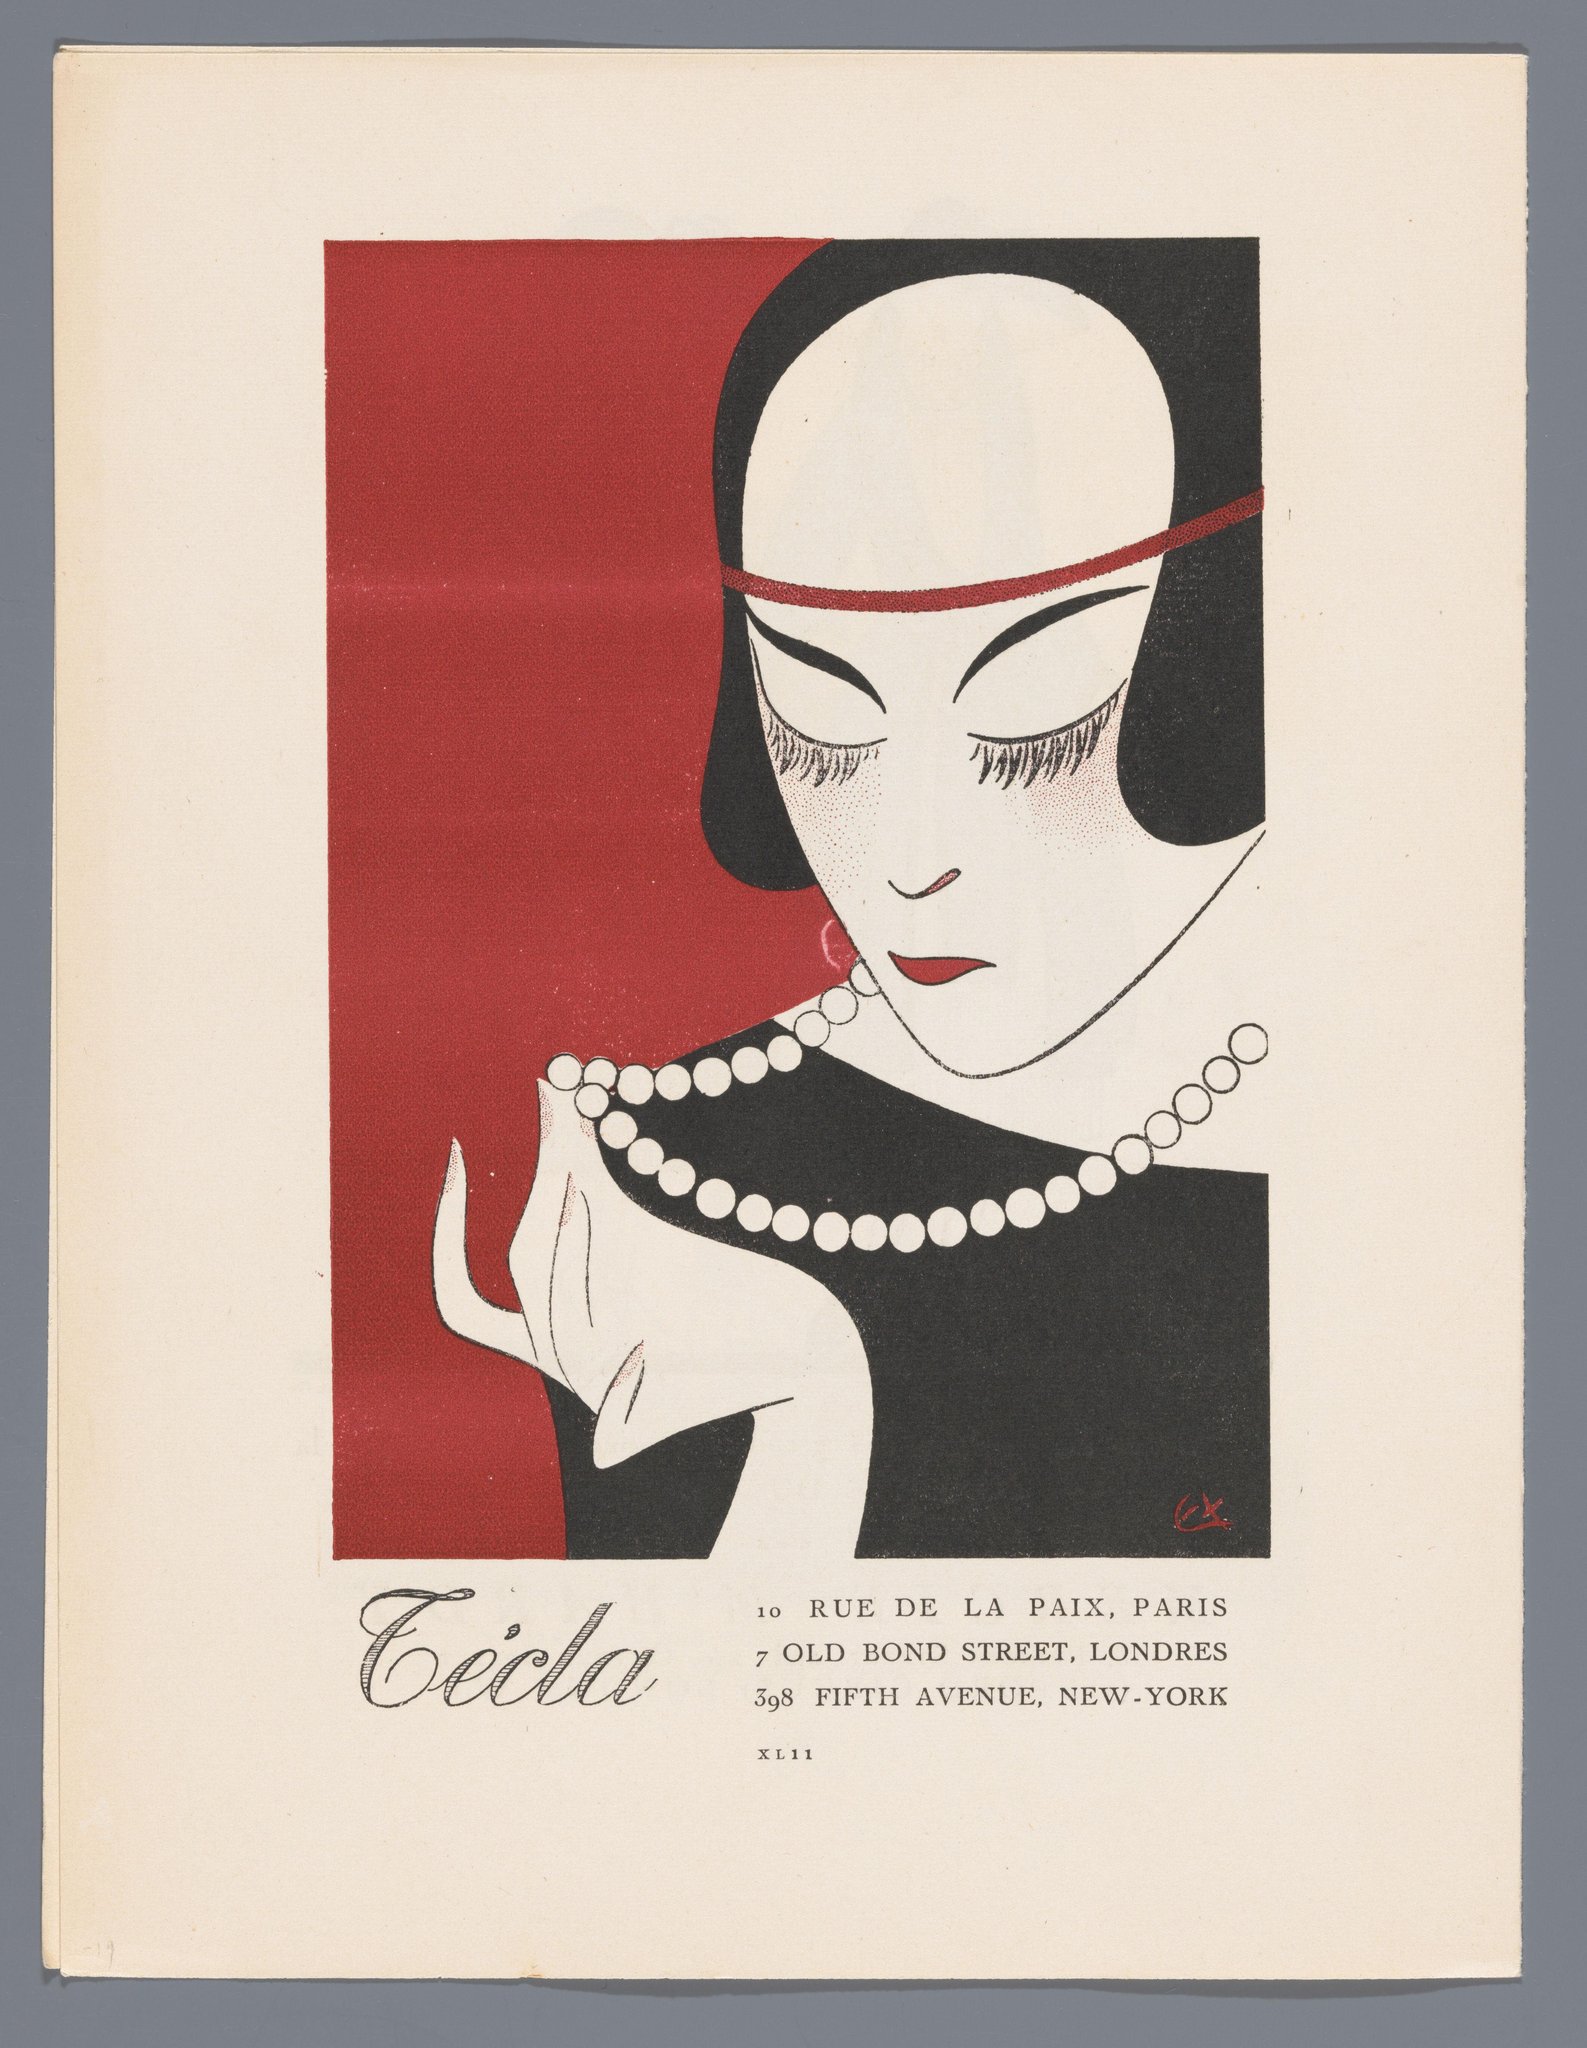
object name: fashion print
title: Gazette du Bon Ton, 1920 - No. 5 : p. XLII: advertentie Técla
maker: lucien vogel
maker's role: publisher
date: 1920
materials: paper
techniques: lithograph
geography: london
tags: fashion plates, pearl; pearl necklace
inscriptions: date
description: Vrouwenhoofd met bandje om het voorhoofd, parelketting om de hals. Compositie in rood, zwart en wit.